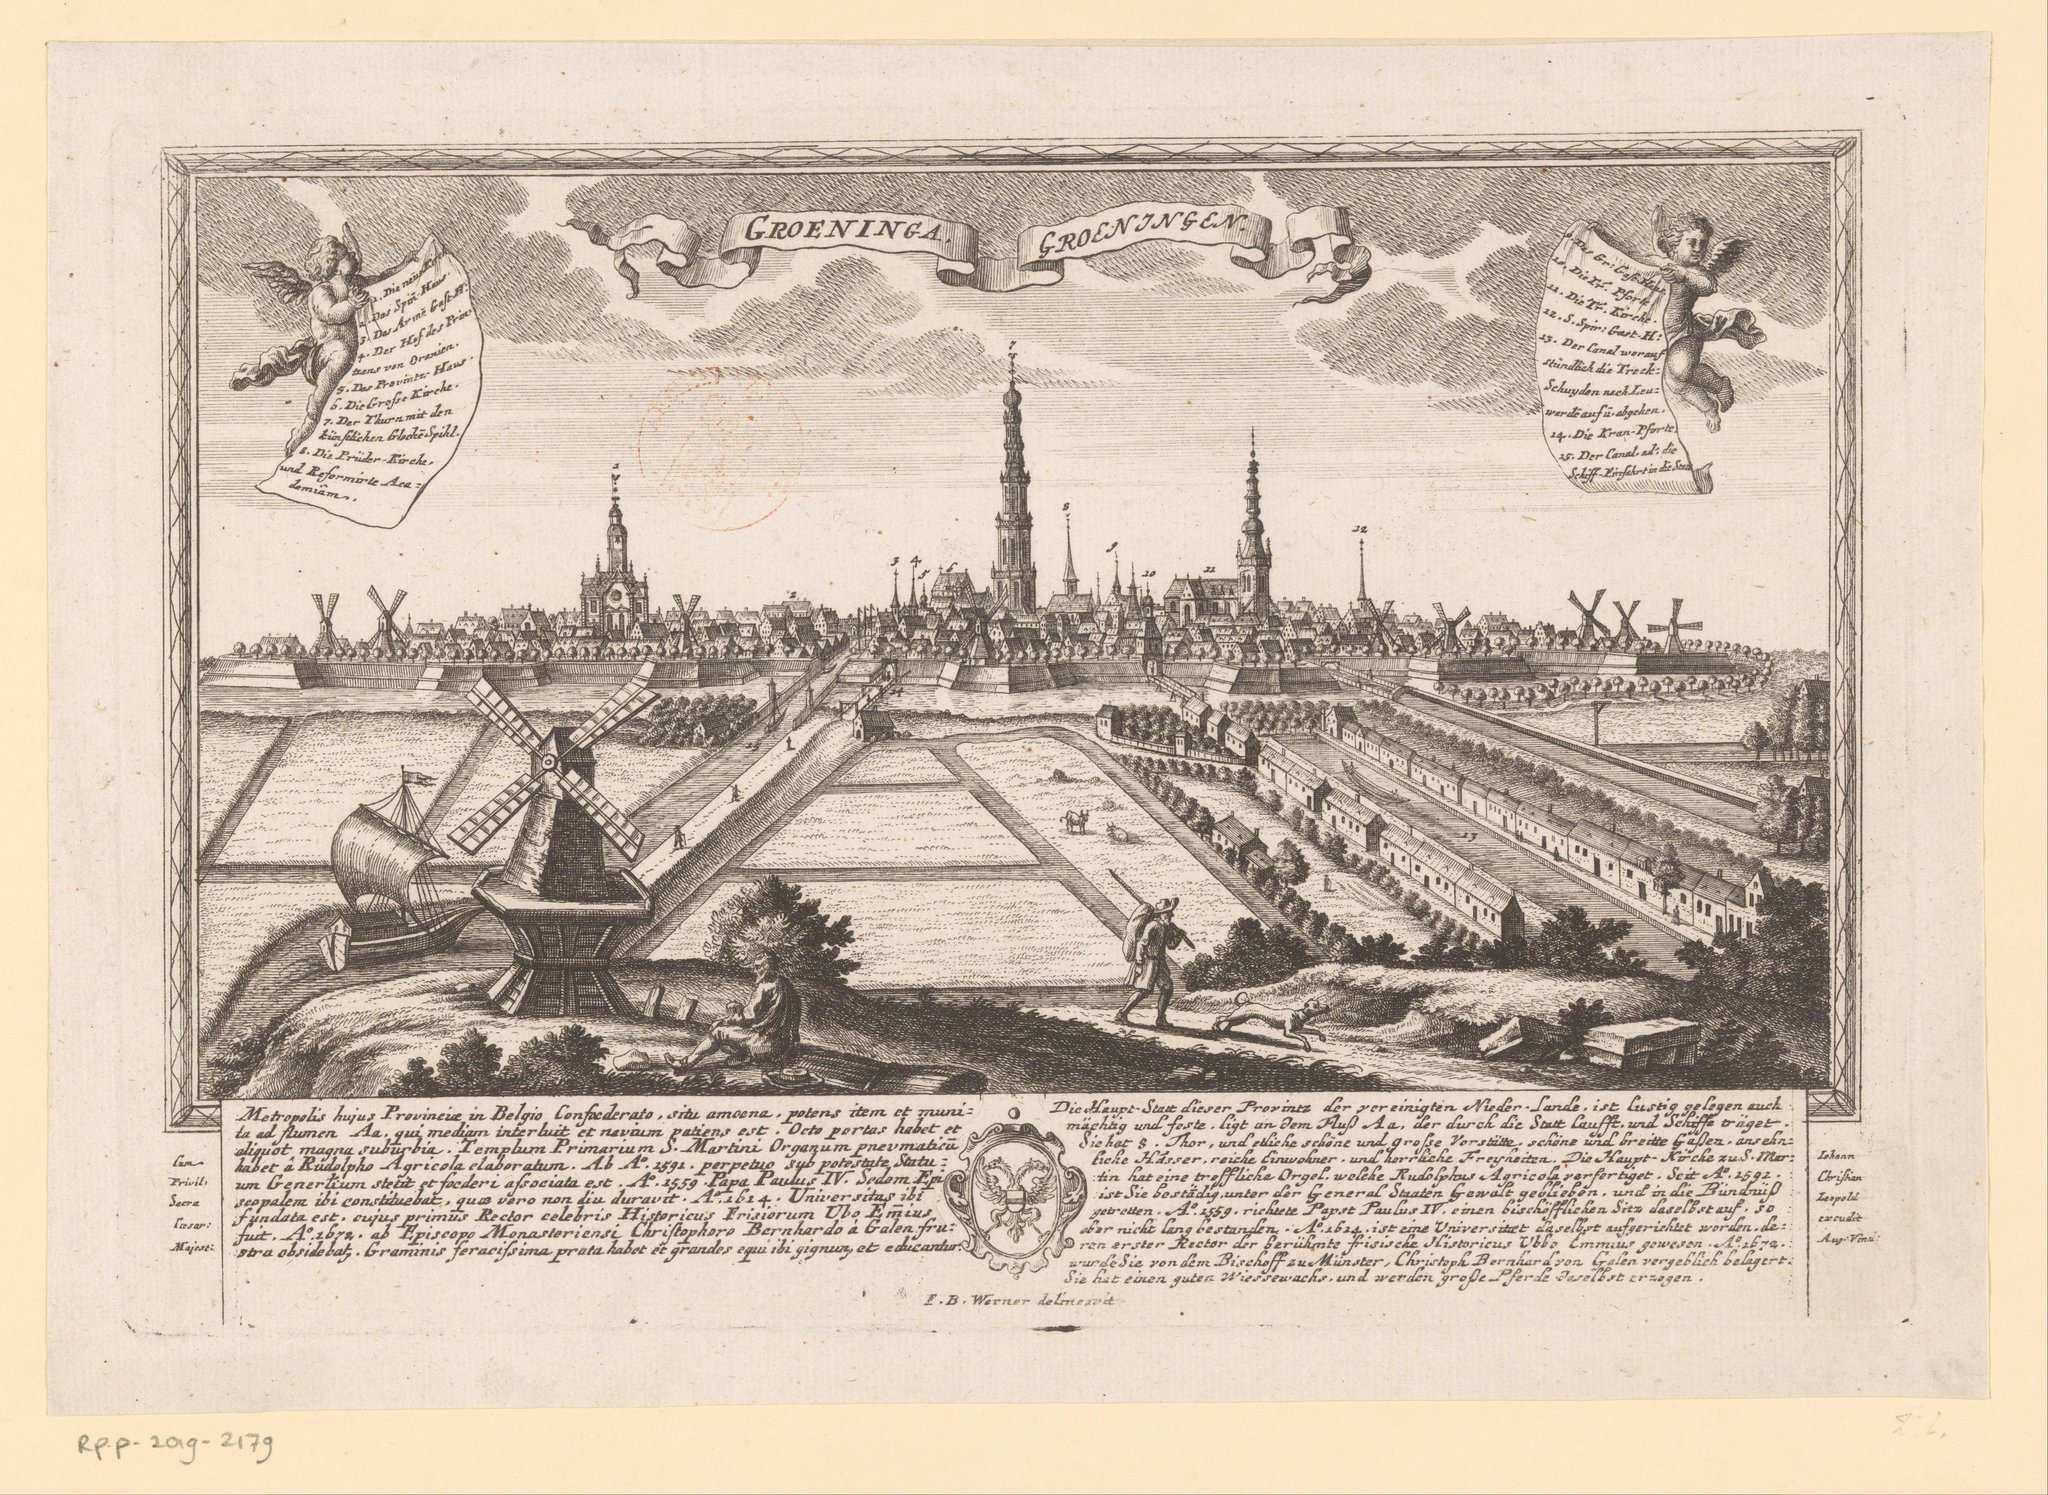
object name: print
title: Gezicht op Groningen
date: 1709-1755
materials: paper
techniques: etching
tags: city-view in general; 'veduta', windmill in landscape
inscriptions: collector's mark